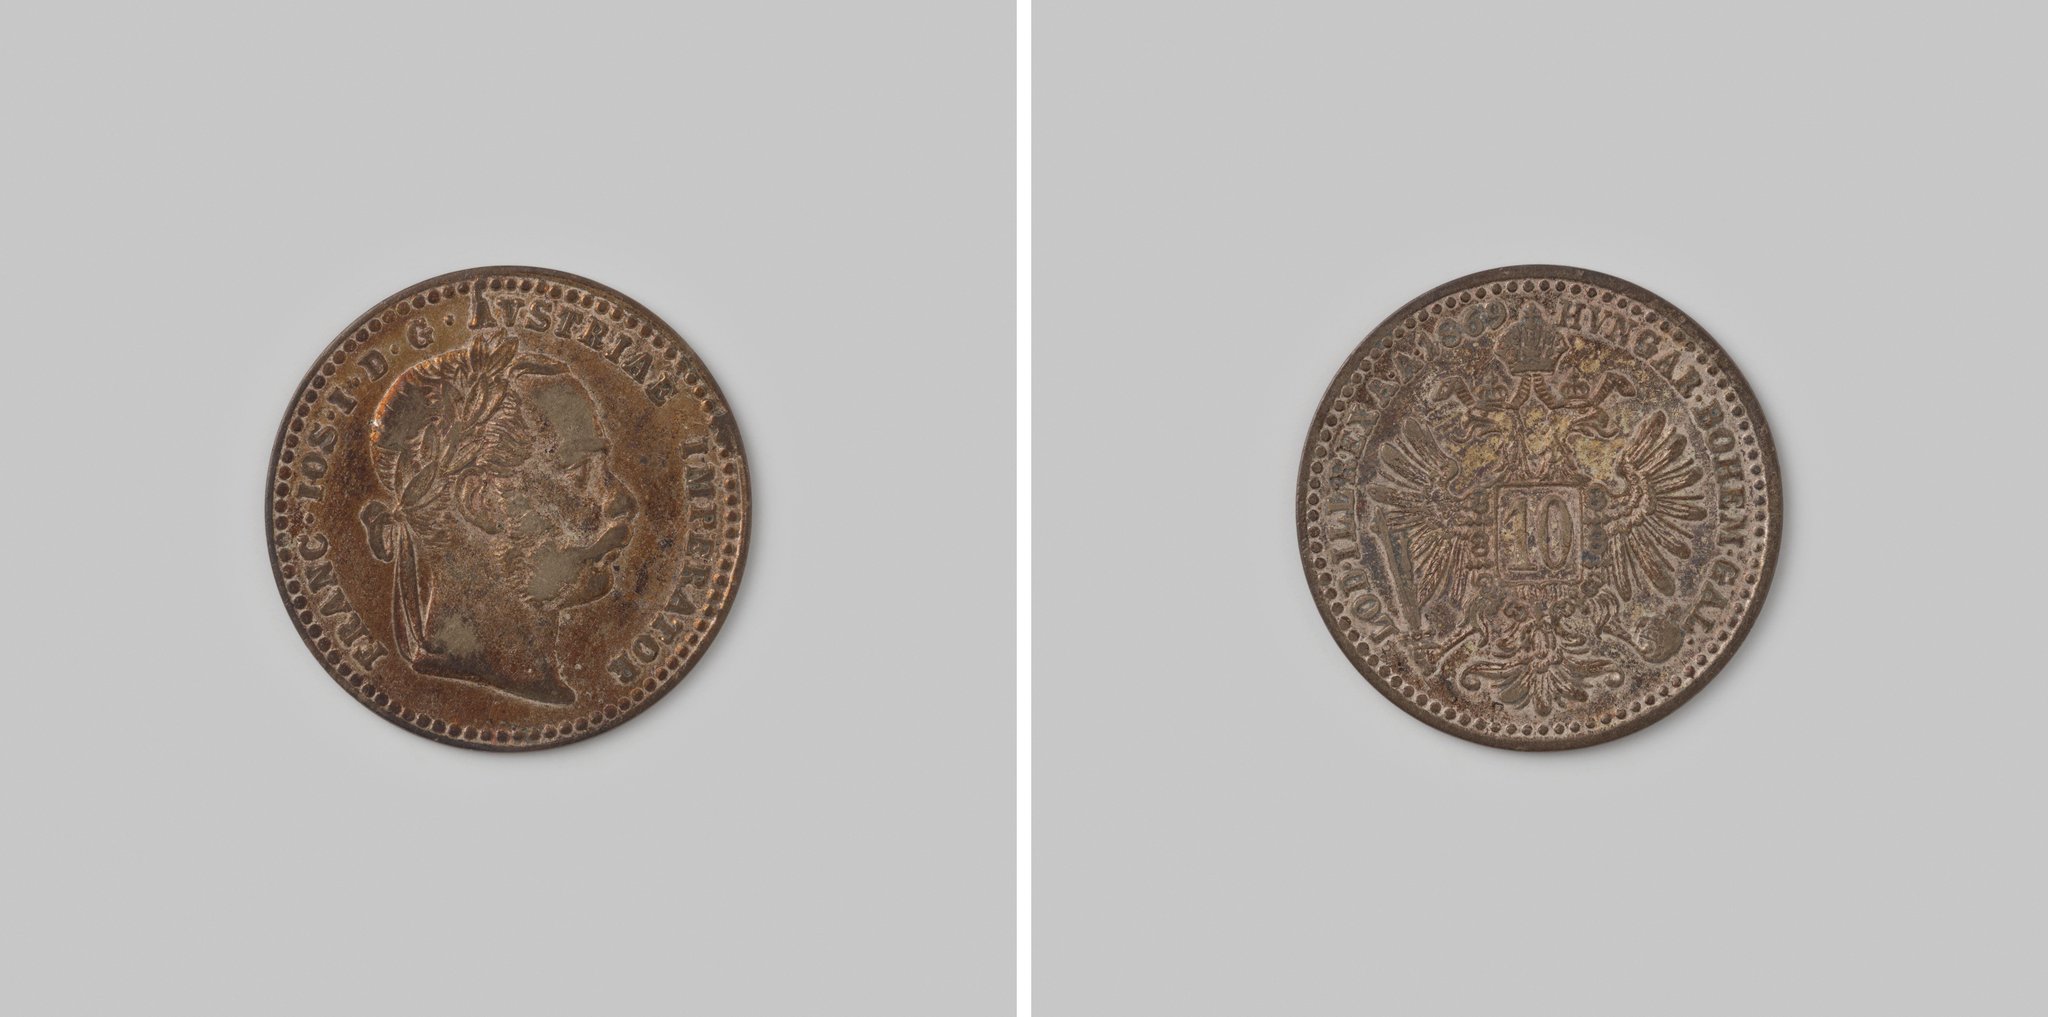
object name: coin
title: 10 Kreuzer uit het keizerrijk Oostenrijk van Franz Joseph, 1869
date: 1869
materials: silver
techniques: striking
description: Zilveren munt. Voorzijde: gelauwerd hoofd van de keizer naar rechts. Keerzijde: gekroonde dubbelkoppige adelaar met op de koppen kleine kronen. Op zijn borst door ridderorde omhangen schild, waarin waarde-aanduiding en in zijn poten een zwaard en een rijksappel. Jaartal aan het eind van het omschrift. Gladde rand.